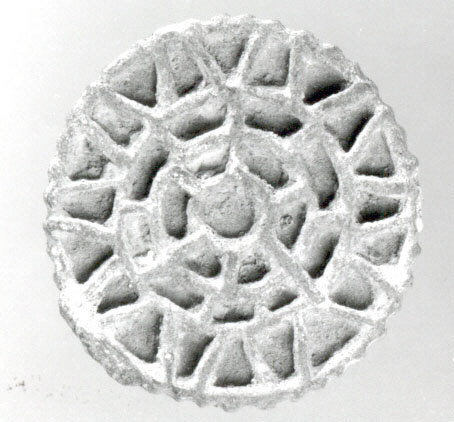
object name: stamp seal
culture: bactria-margiana archaeological complex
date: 2333-1668 BCE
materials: copper alloy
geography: bactria-margiana